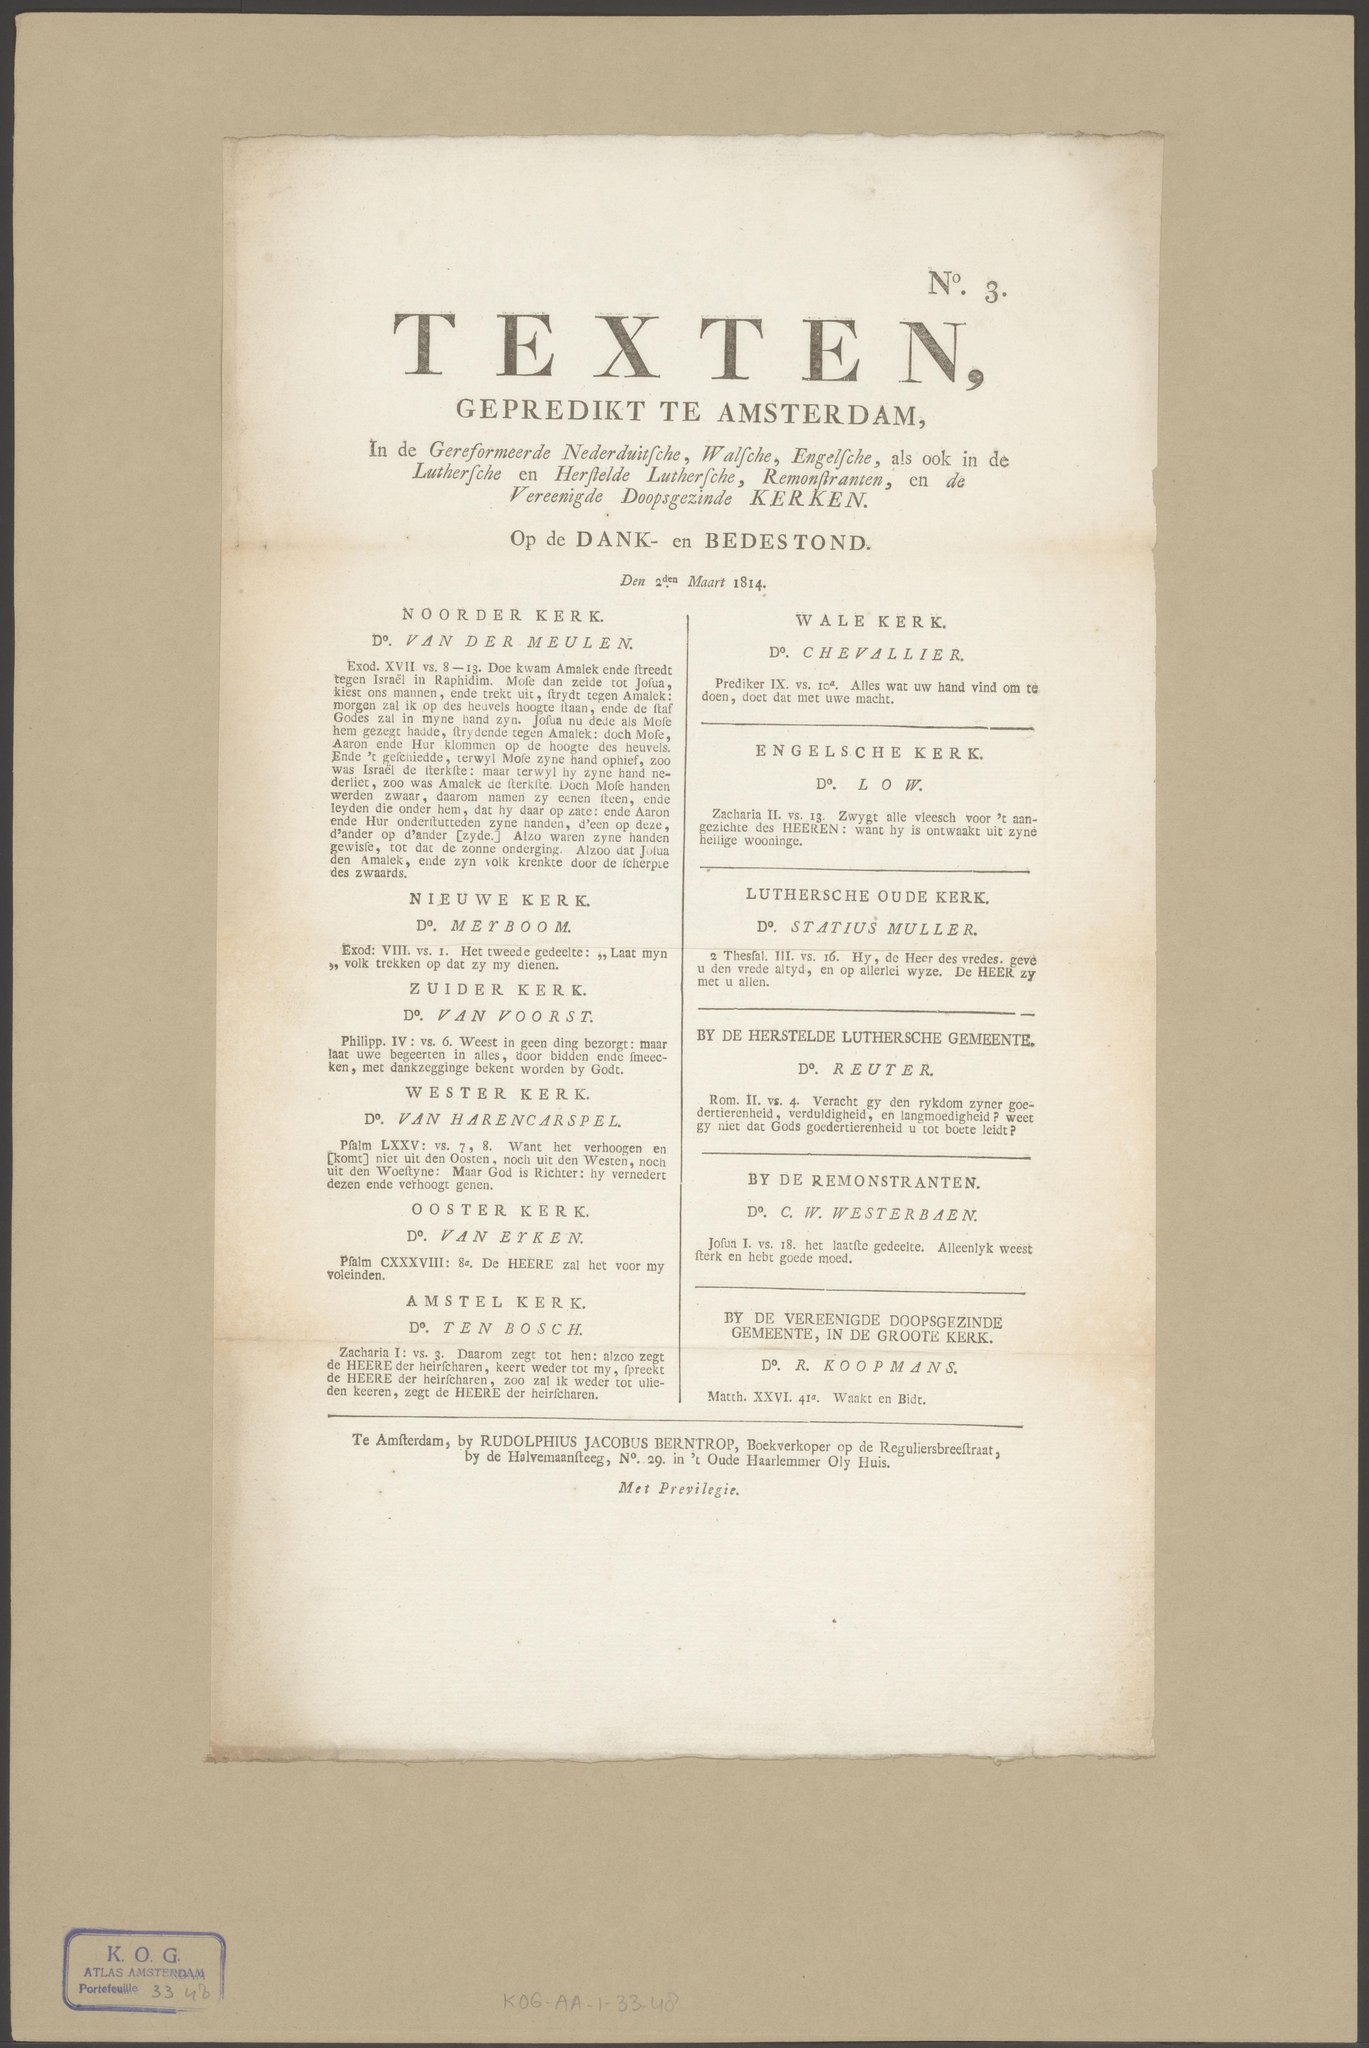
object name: list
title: Texten, gepredikt te Amsterdam, in de Gereformeerde Nederduitsche, Walsche, Engelsche, als ook in de Luthersche en Herstelde Luthersche, Remonstranten, en de Vereenigde Doopsgezinde kerken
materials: paper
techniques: letterpress printing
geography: amsterdam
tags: preaching (in general)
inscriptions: collector's mark: Lugt 1641b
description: Rechtsboven genummerd: No. 3. Onderwerpsrubriek binnen de Atlas Amsterdam: Kerkwezen: Hervormde Gemeente: Predikbeurtenlijsten 1814, 1867.